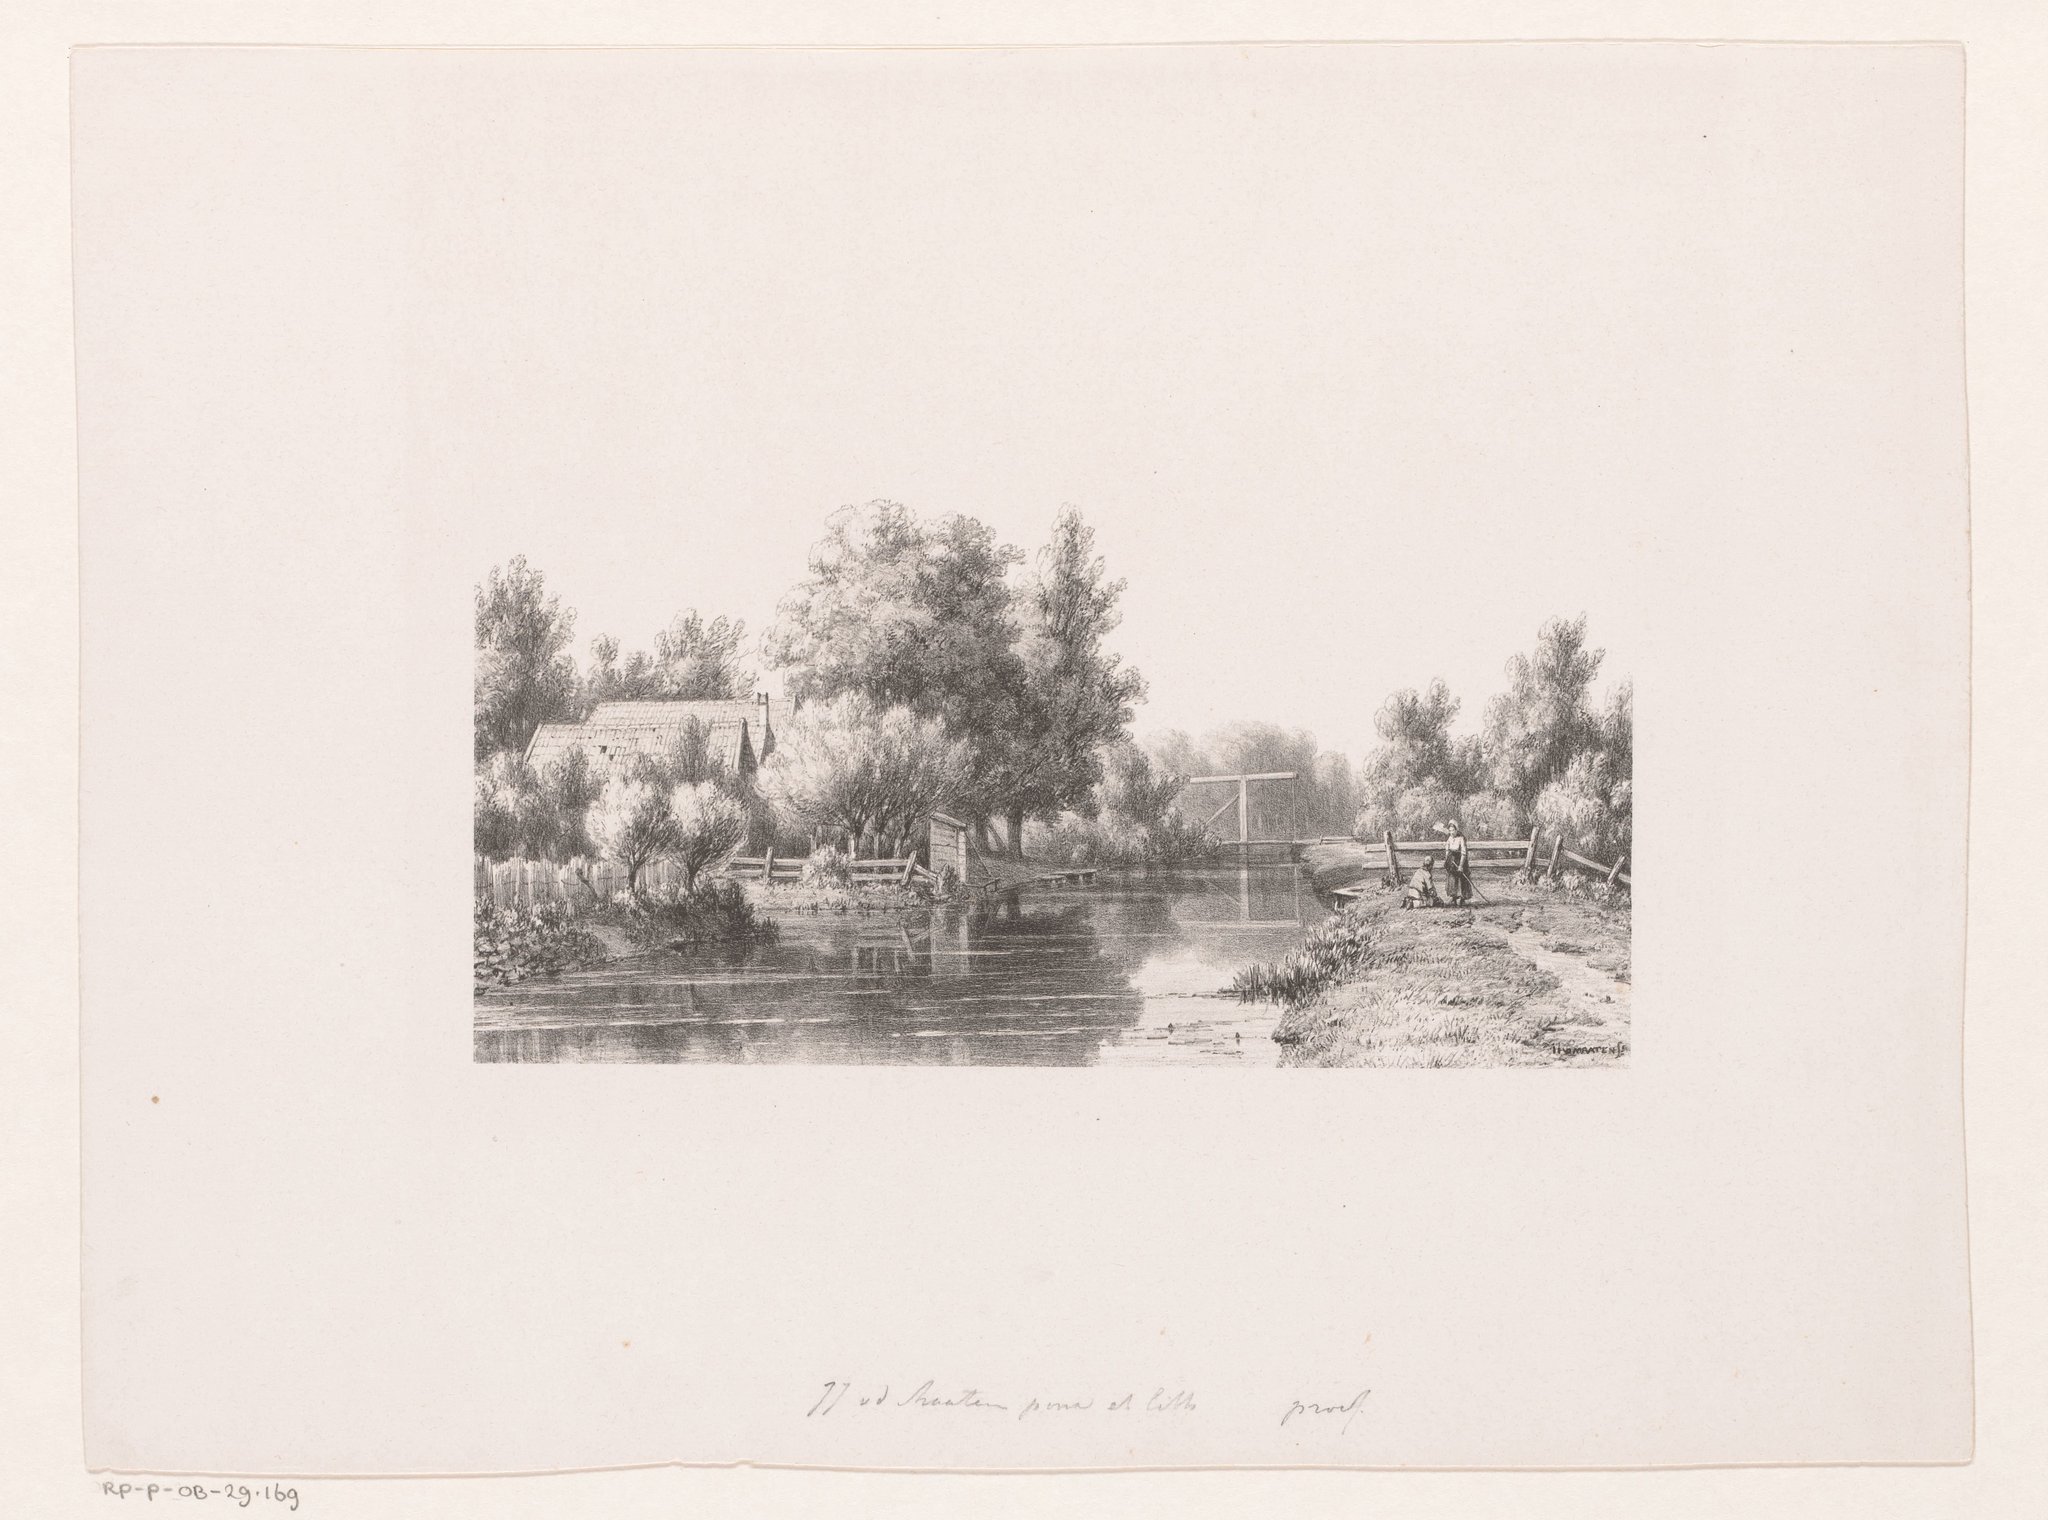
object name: print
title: Gezicht op een rivier met boerderij en ophaalbrug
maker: jacob jan van der maaten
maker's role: draughtsman, print maker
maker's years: 1820-1879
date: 1830-1879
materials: paper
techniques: lithograph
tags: landscape with bridge, viaduct or aqueduct, river (+ landscape with figures, staffage)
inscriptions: inscription: ‘J J v d Maaten pinx et lith proef’, collector's mark: Lugt 2228